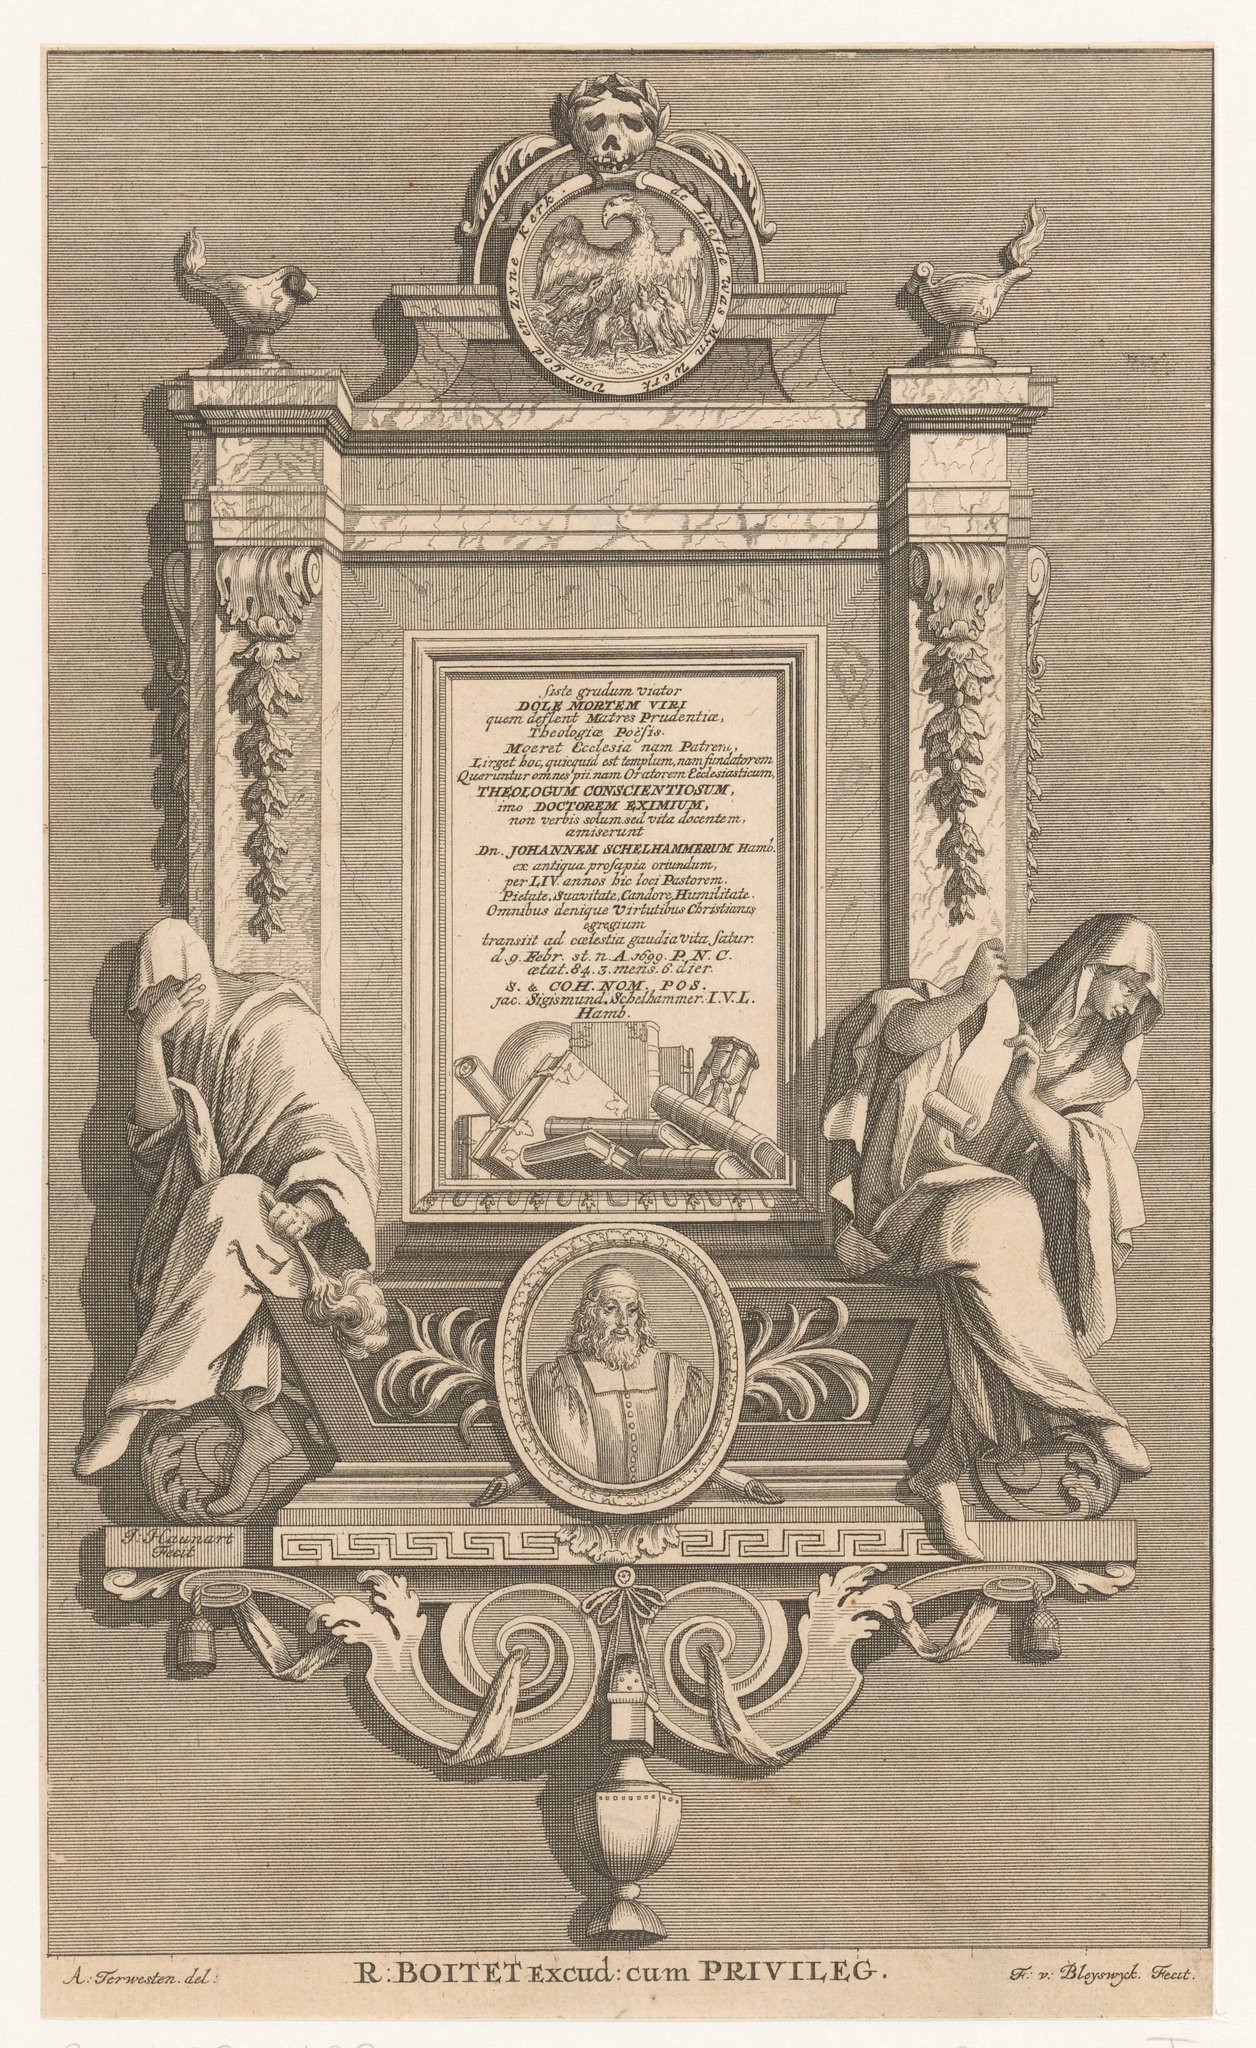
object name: print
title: Grafmonument voor Johannes Schelhammer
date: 1730-1736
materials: paper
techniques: etching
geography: leiden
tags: the hague, johannes schelhammer, 'pleurants', epitaph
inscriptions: collector's mark: Lugt 2228, collector's mark: Lugt 2760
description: Grafmonument of epitaaf voor Duitse theoloog Johannes Schelhammer in de Evangelisch Lutherse kerk aan de Lutherse Burgwal te Den Haag. Een plaat met Latijns opschrift ter nagedachtenis aan hem is het middelpunt van een architecturale omlijsting. Deze wordt bekroond met een medaillon waarop het symbool van Christus' lijden is afgebeeld: een pelikaan voedt haar jongen met haar eigen bloed. Twee treurende vrouwen flankeren een portret van Schelhammer.